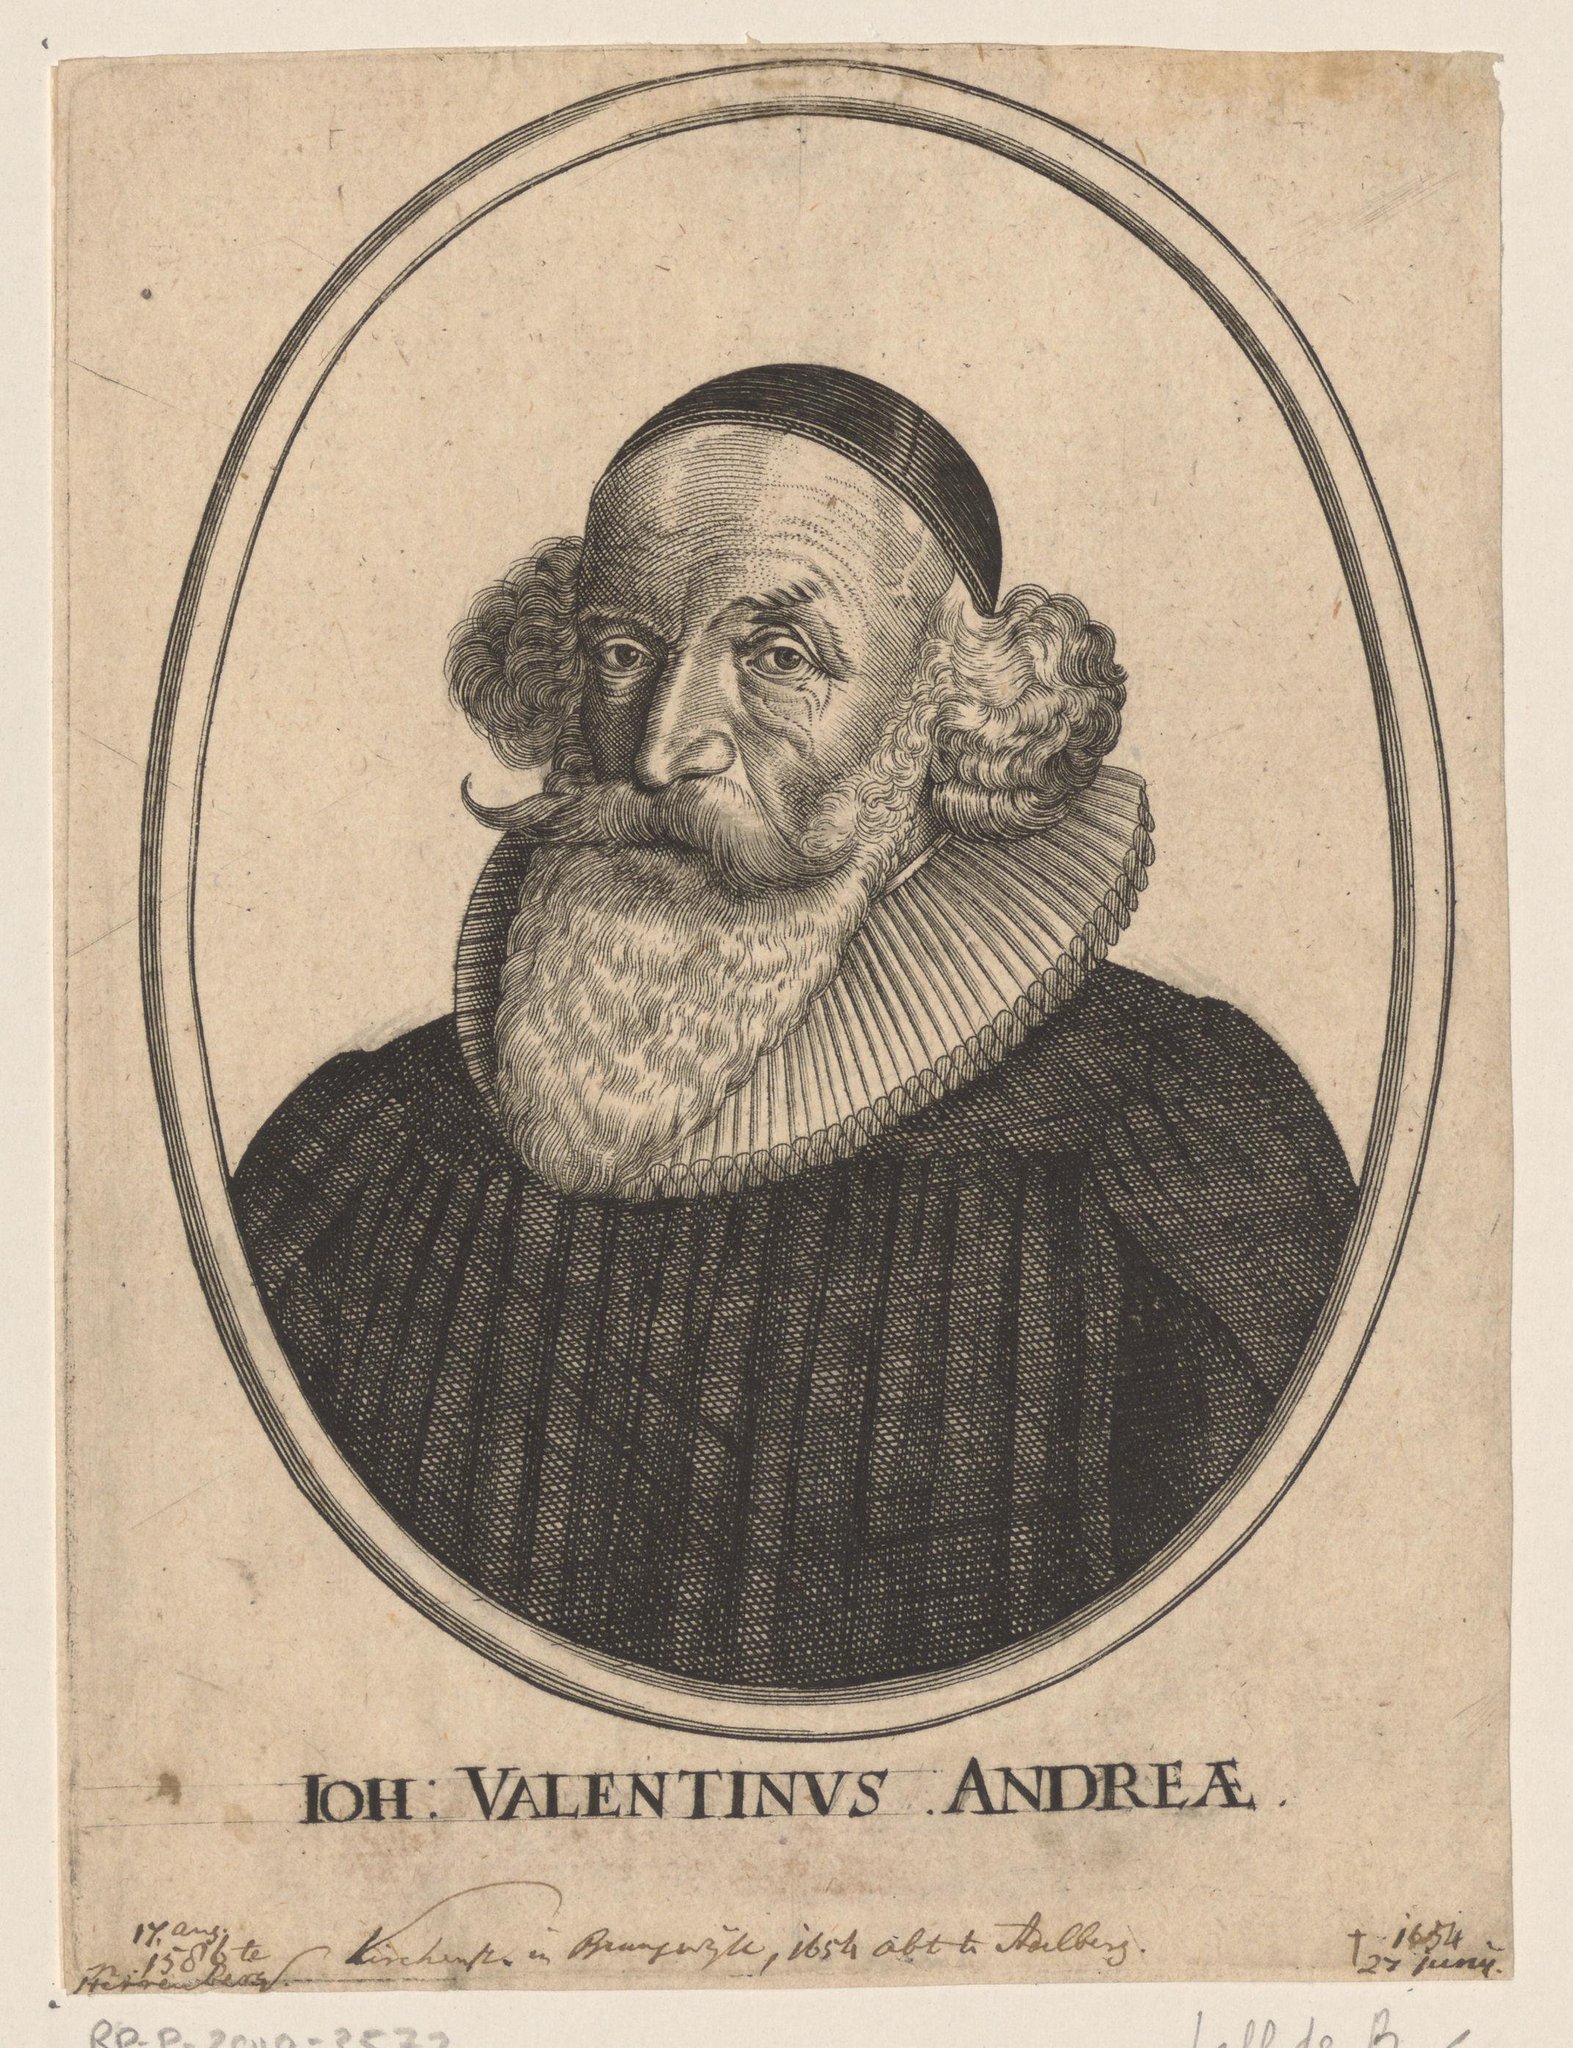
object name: print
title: Portret van Johann Valentin Andreae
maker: Anonymous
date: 1650-1699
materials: paper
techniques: engraving, etching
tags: theologian, historical persons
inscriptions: inscription: ‘[...]’